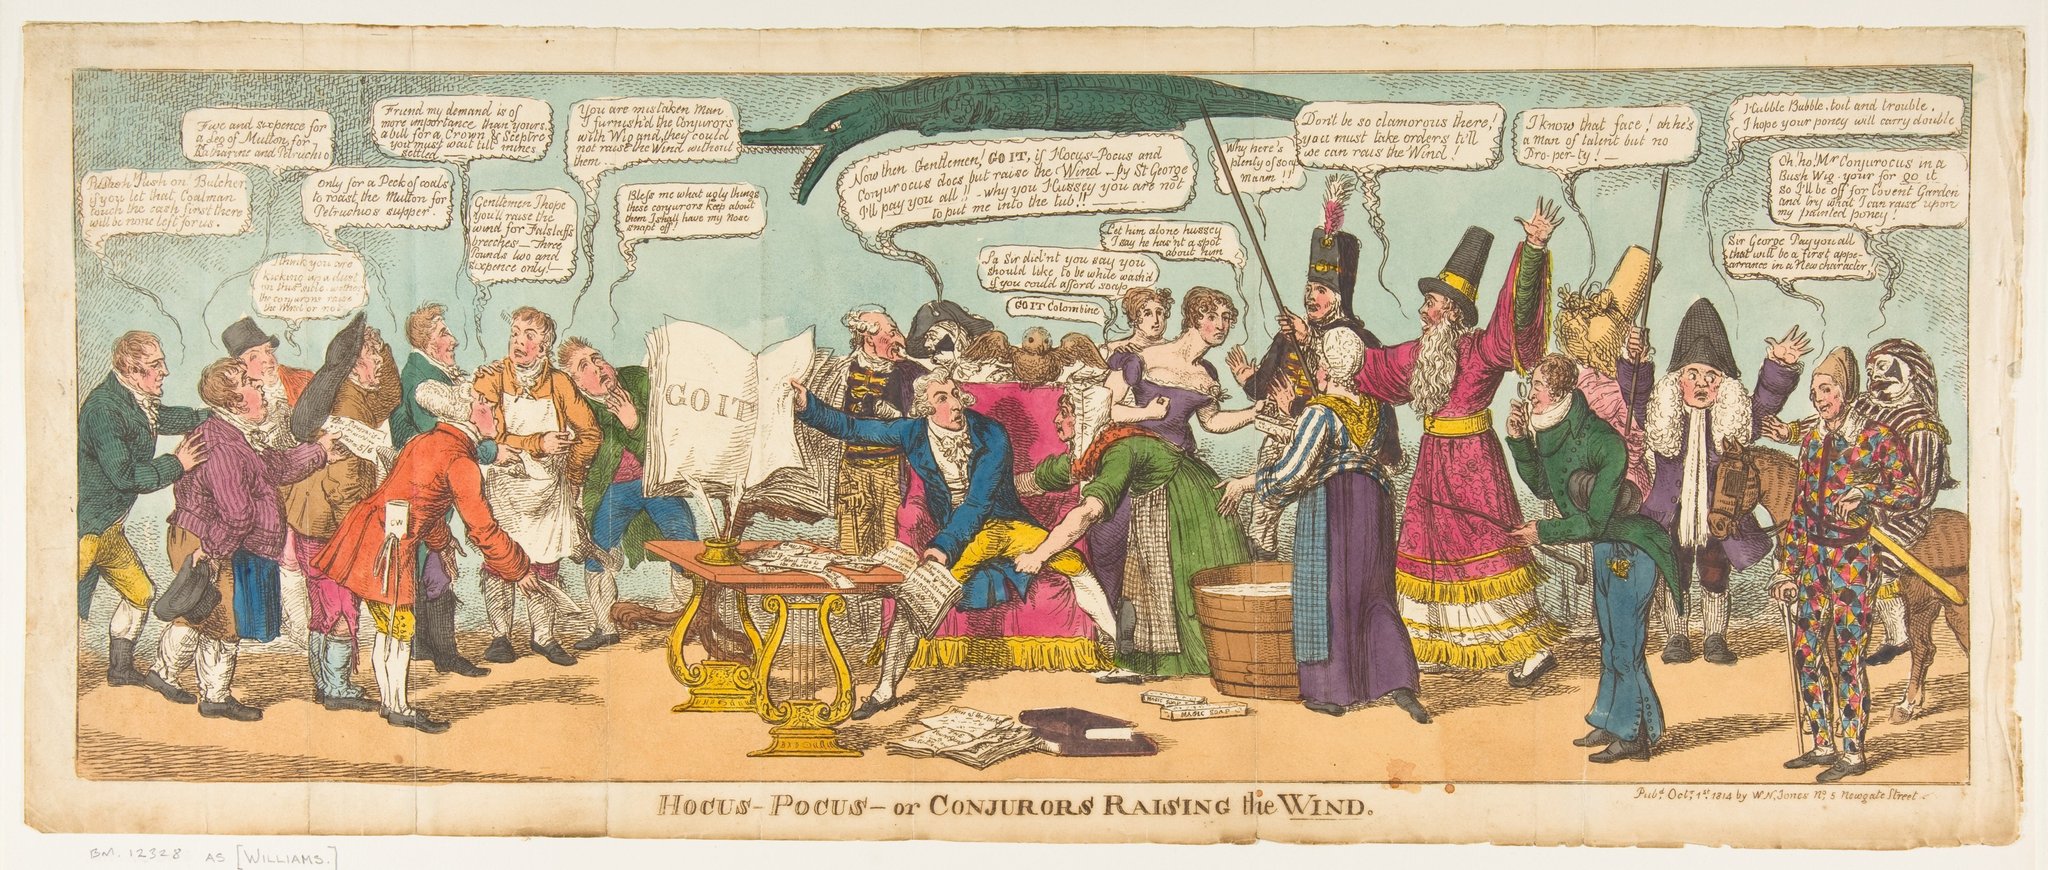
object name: print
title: Hocus Pocus–or Conjurors Raising the Wind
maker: charles williams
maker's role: artist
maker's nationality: british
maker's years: 1750-1850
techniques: etching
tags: satire,men,women,crocodiles